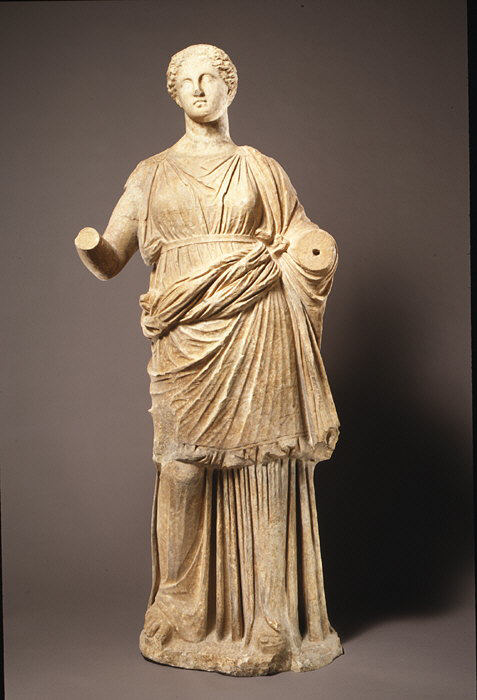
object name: statue of a woman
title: Marble statue of a woman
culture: greek, attic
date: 334-301 BCE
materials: marble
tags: women